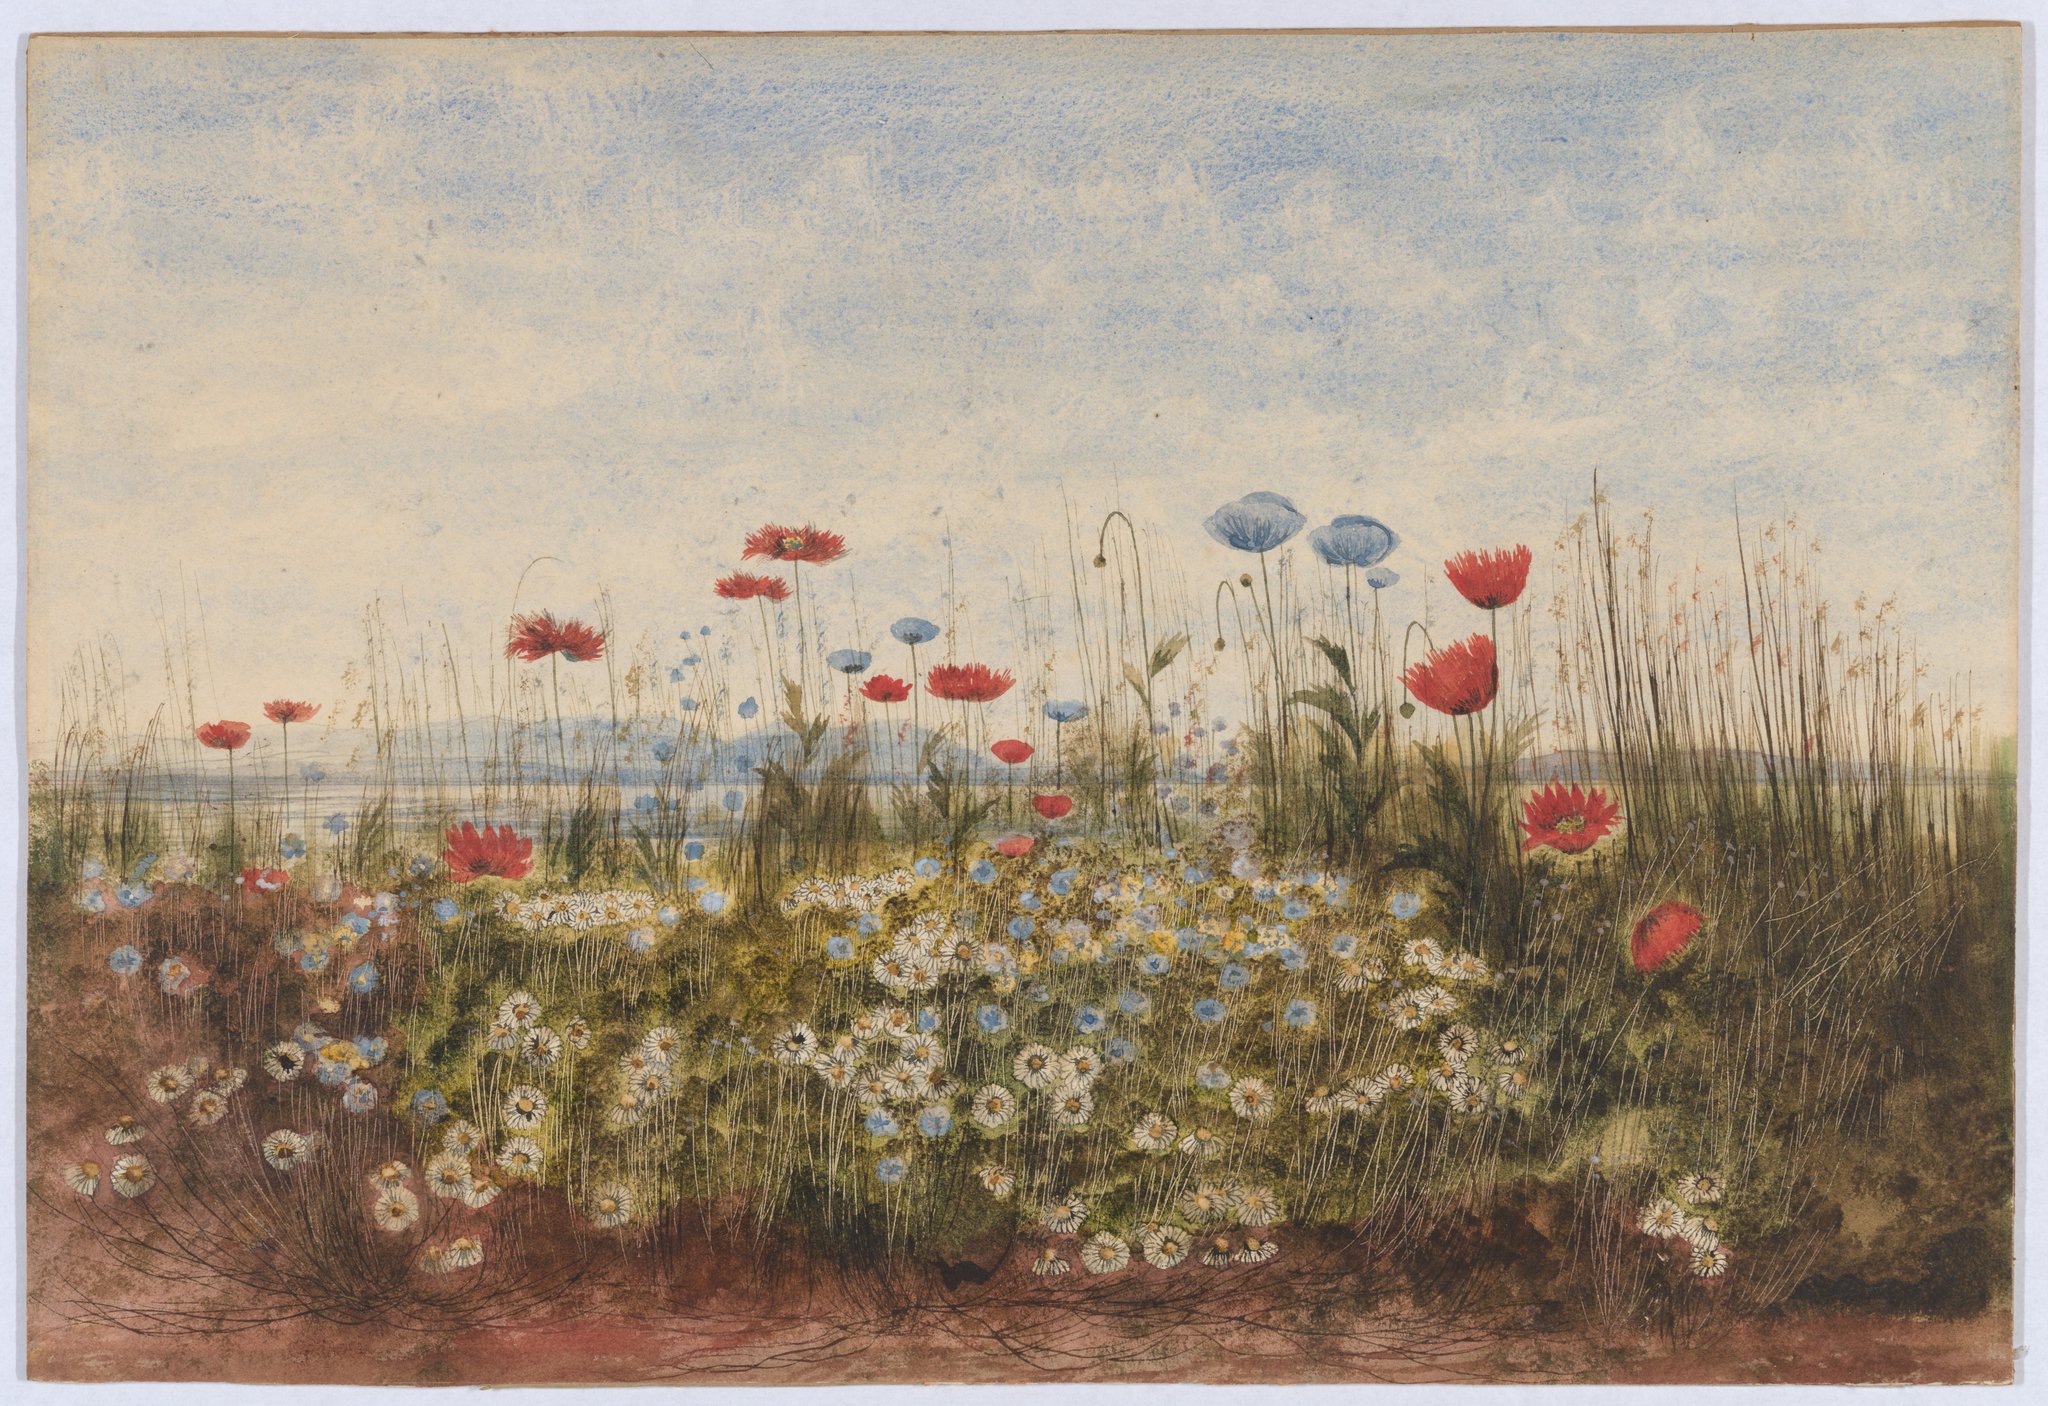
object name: drawing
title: Bank of wildflowers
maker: andrew nicholl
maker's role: artist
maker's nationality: irish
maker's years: 1804-1886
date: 1830-1839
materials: gouache, watercolor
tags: flowers